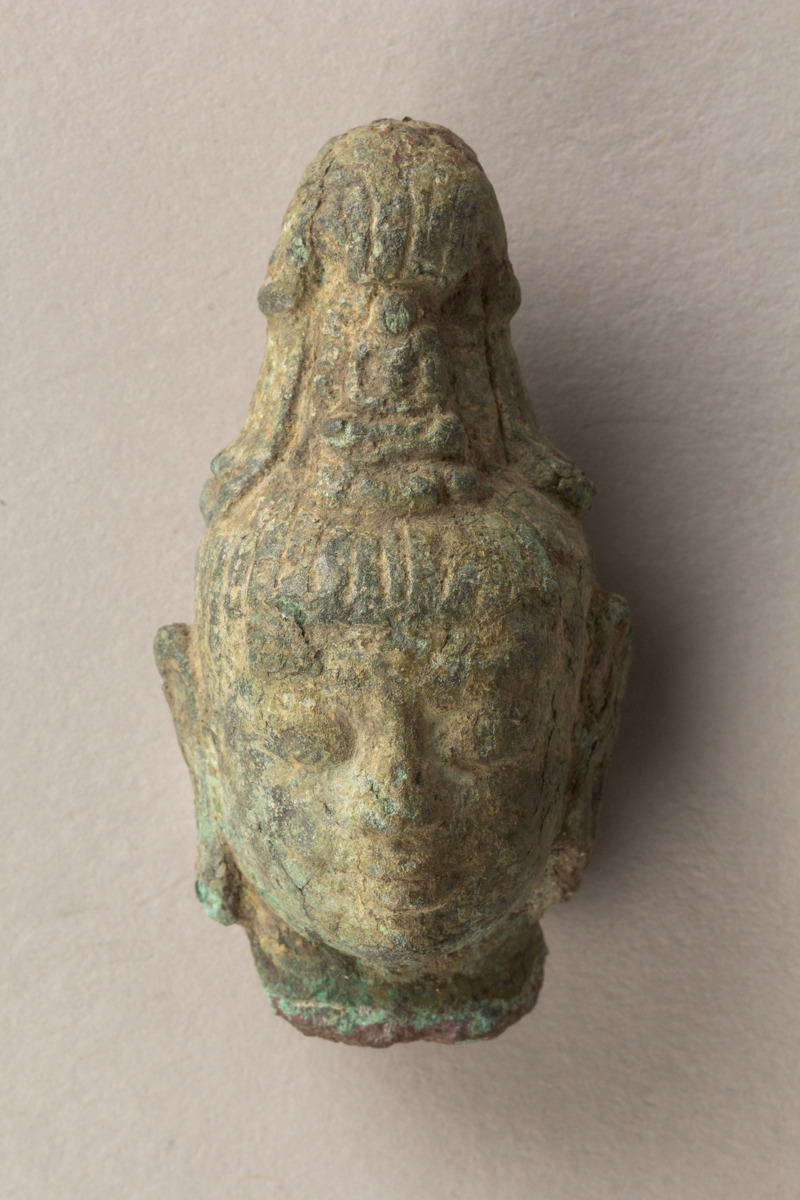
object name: fragment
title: Fragment of a Head of Avalokiteshvara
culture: indonesian, kalimantan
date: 701-800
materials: bronze